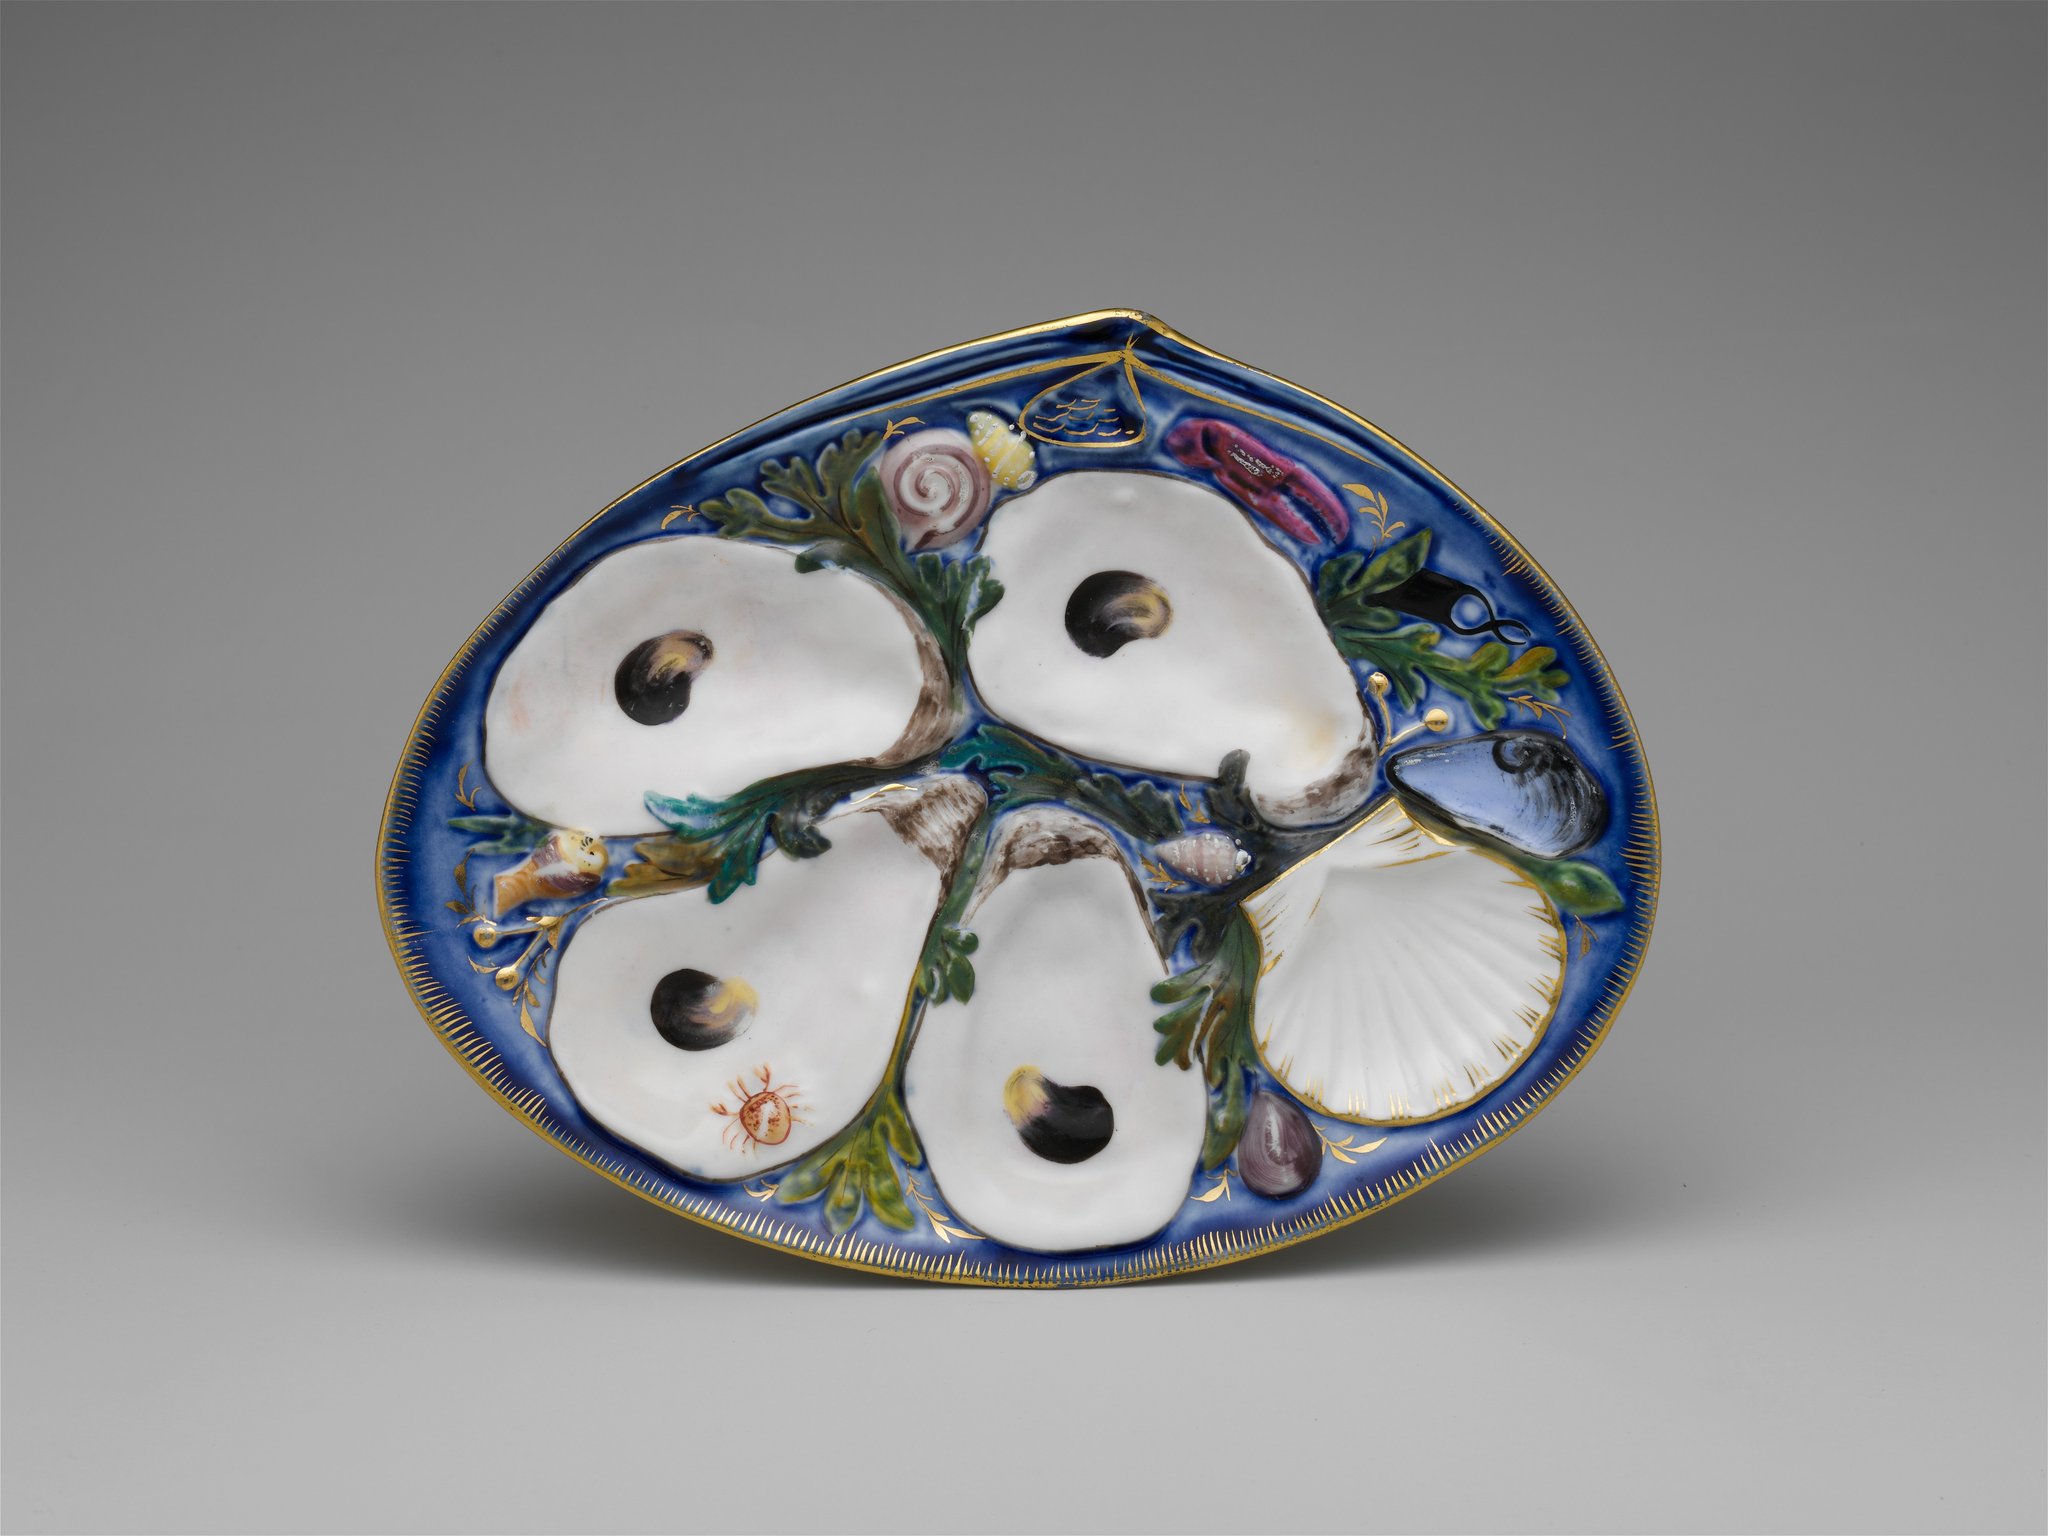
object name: oyster plate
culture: american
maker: union porcelain works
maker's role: maker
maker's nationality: american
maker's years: 1863-1922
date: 1881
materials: porcelain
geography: united states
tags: shells